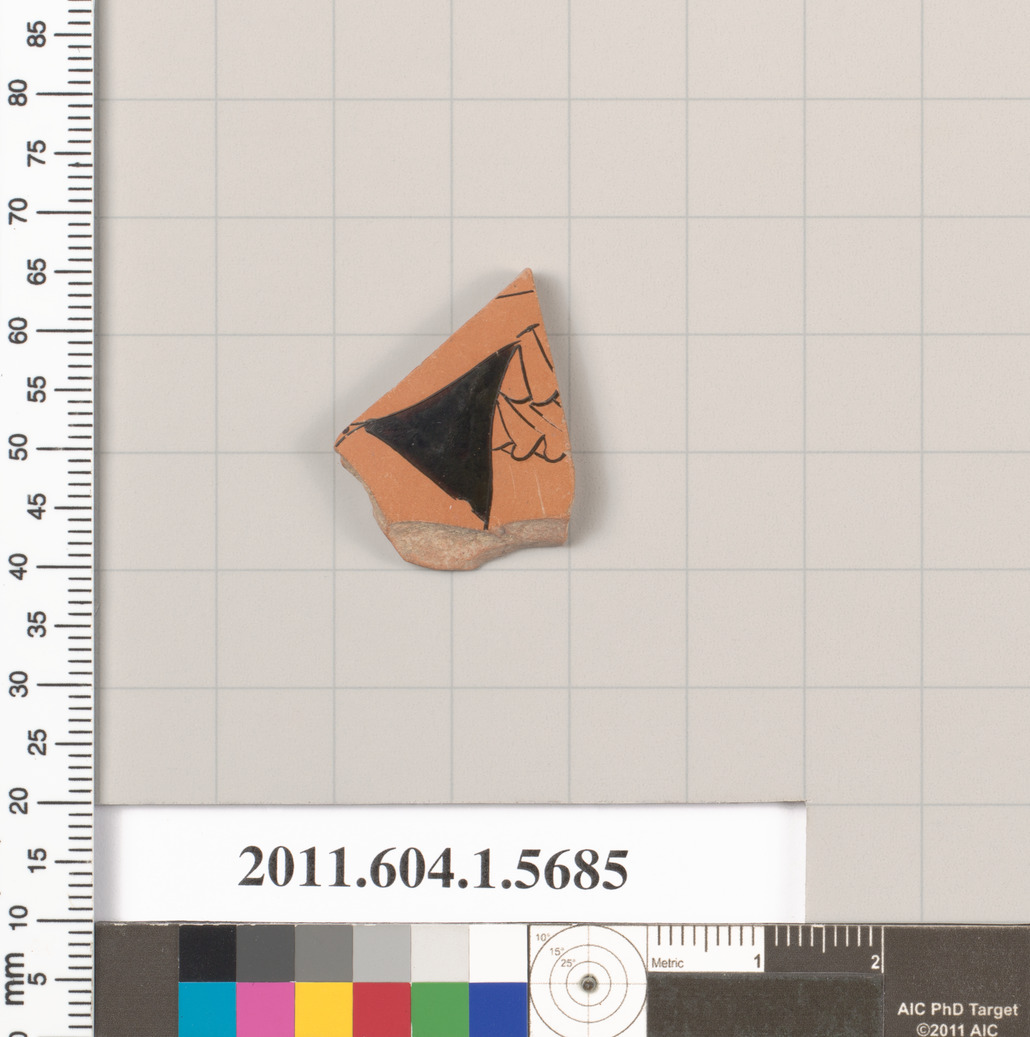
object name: kylix fragment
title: Terracotta fragment of a kylix (drinking cup)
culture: greek, attic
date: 500-480 BCE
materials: terracotta